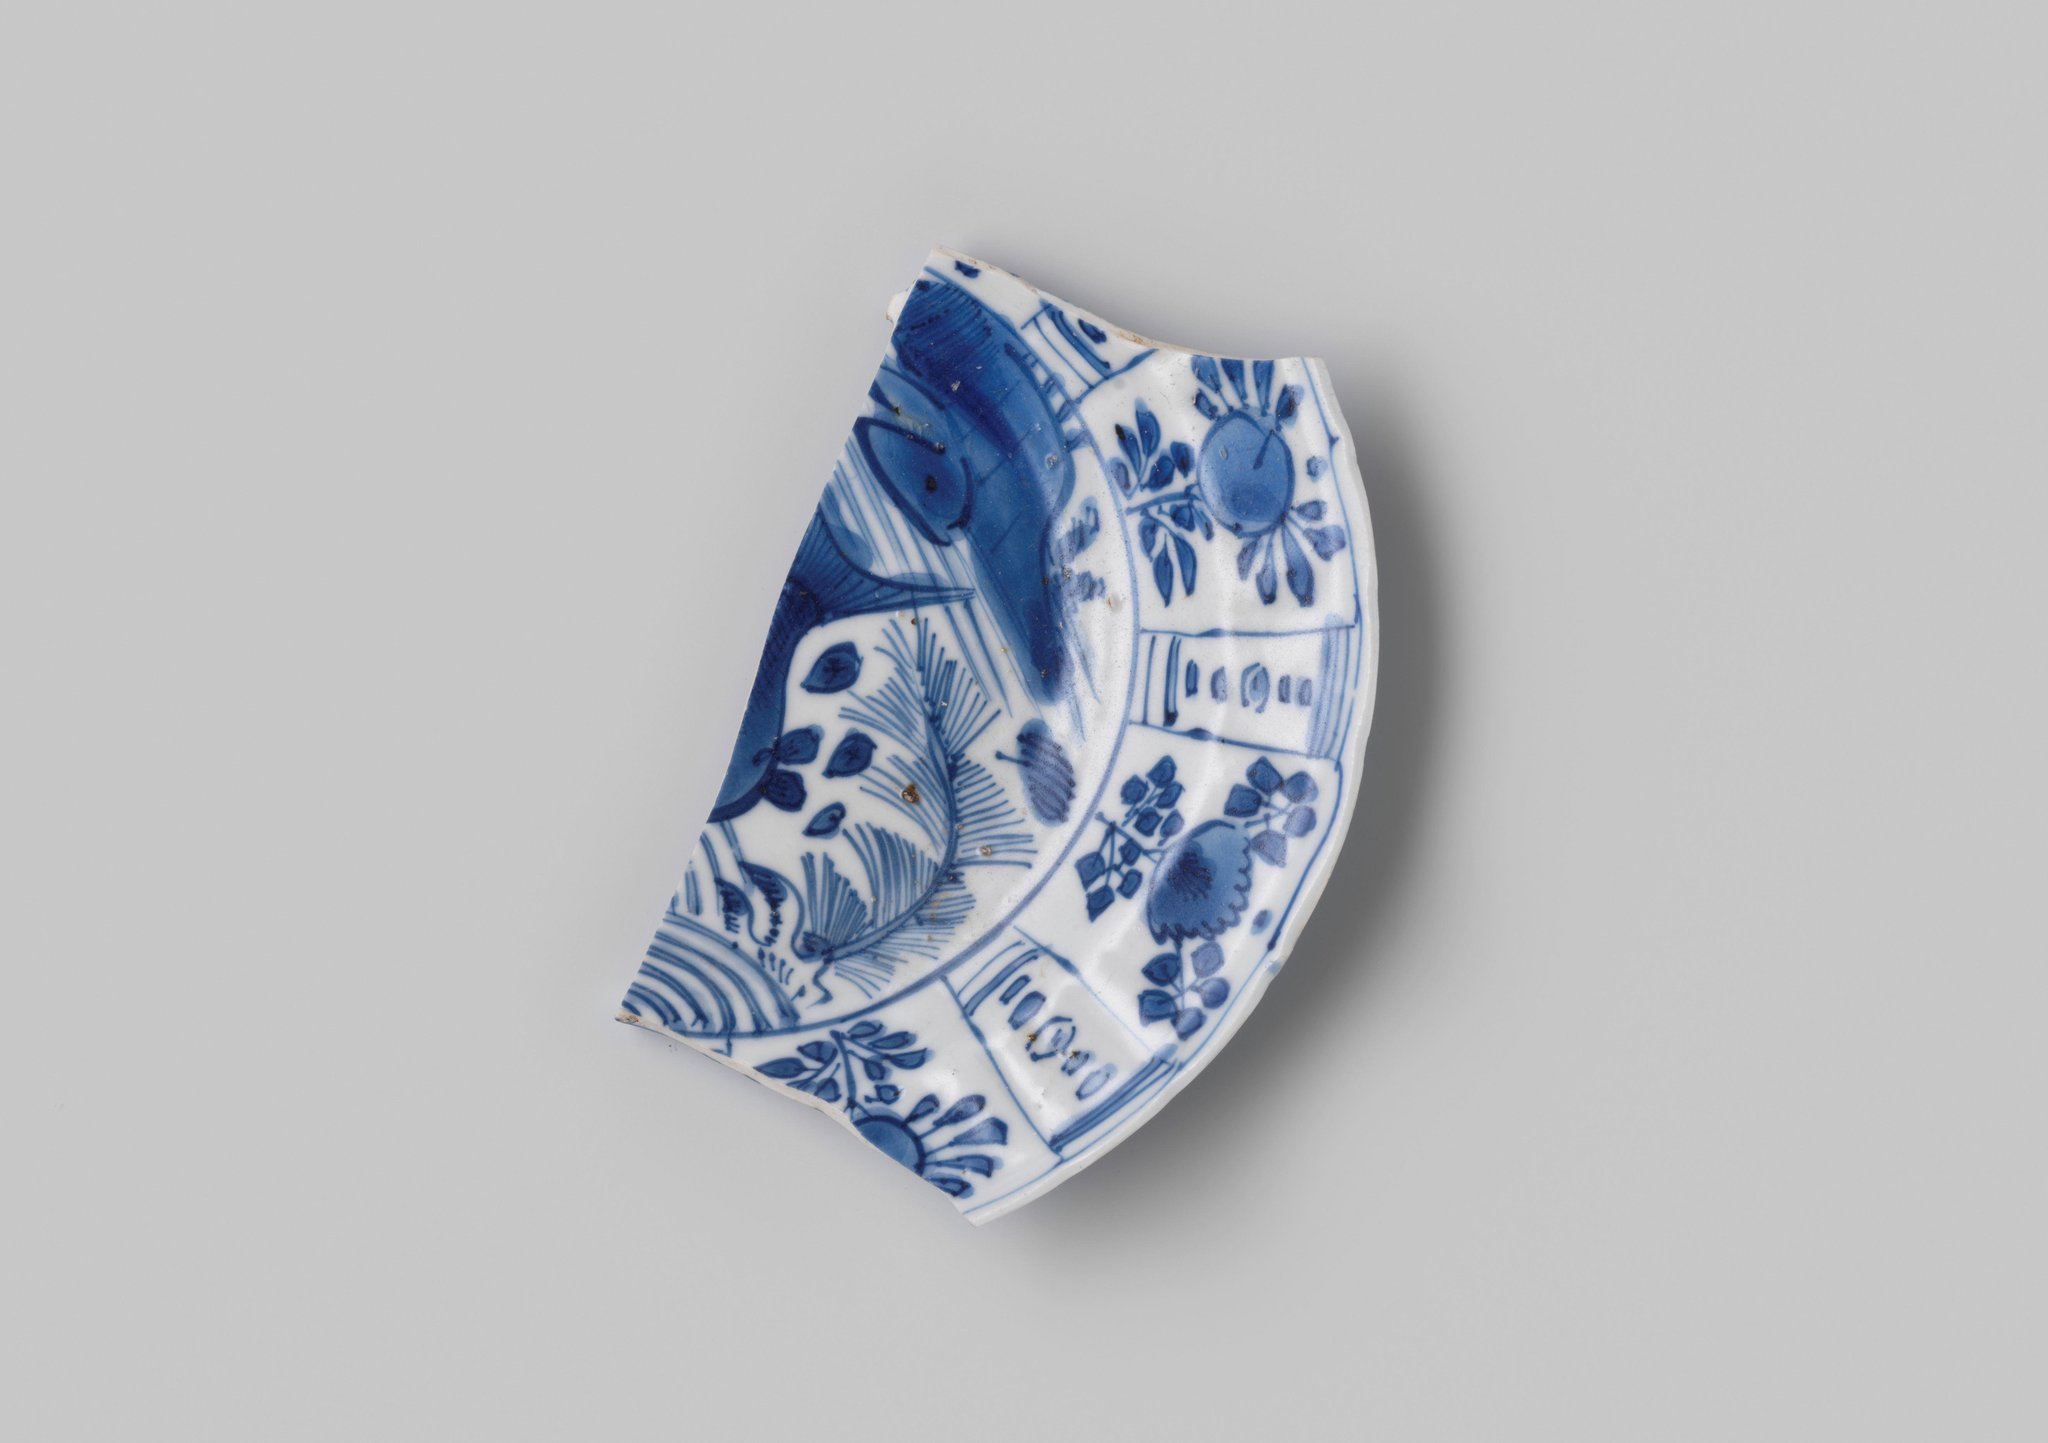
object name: sherd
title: Fragment bord uit V.O.C.-schip de 'Witte Leeuw'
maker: Anonymous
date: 1613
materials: bone china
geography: jingdezhen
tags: verenigde oostindische compagnie, sint-helena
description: A saucer with a flattened rim. A central decoration of a fish and weeds. Panels decorated with peaches and flowers.